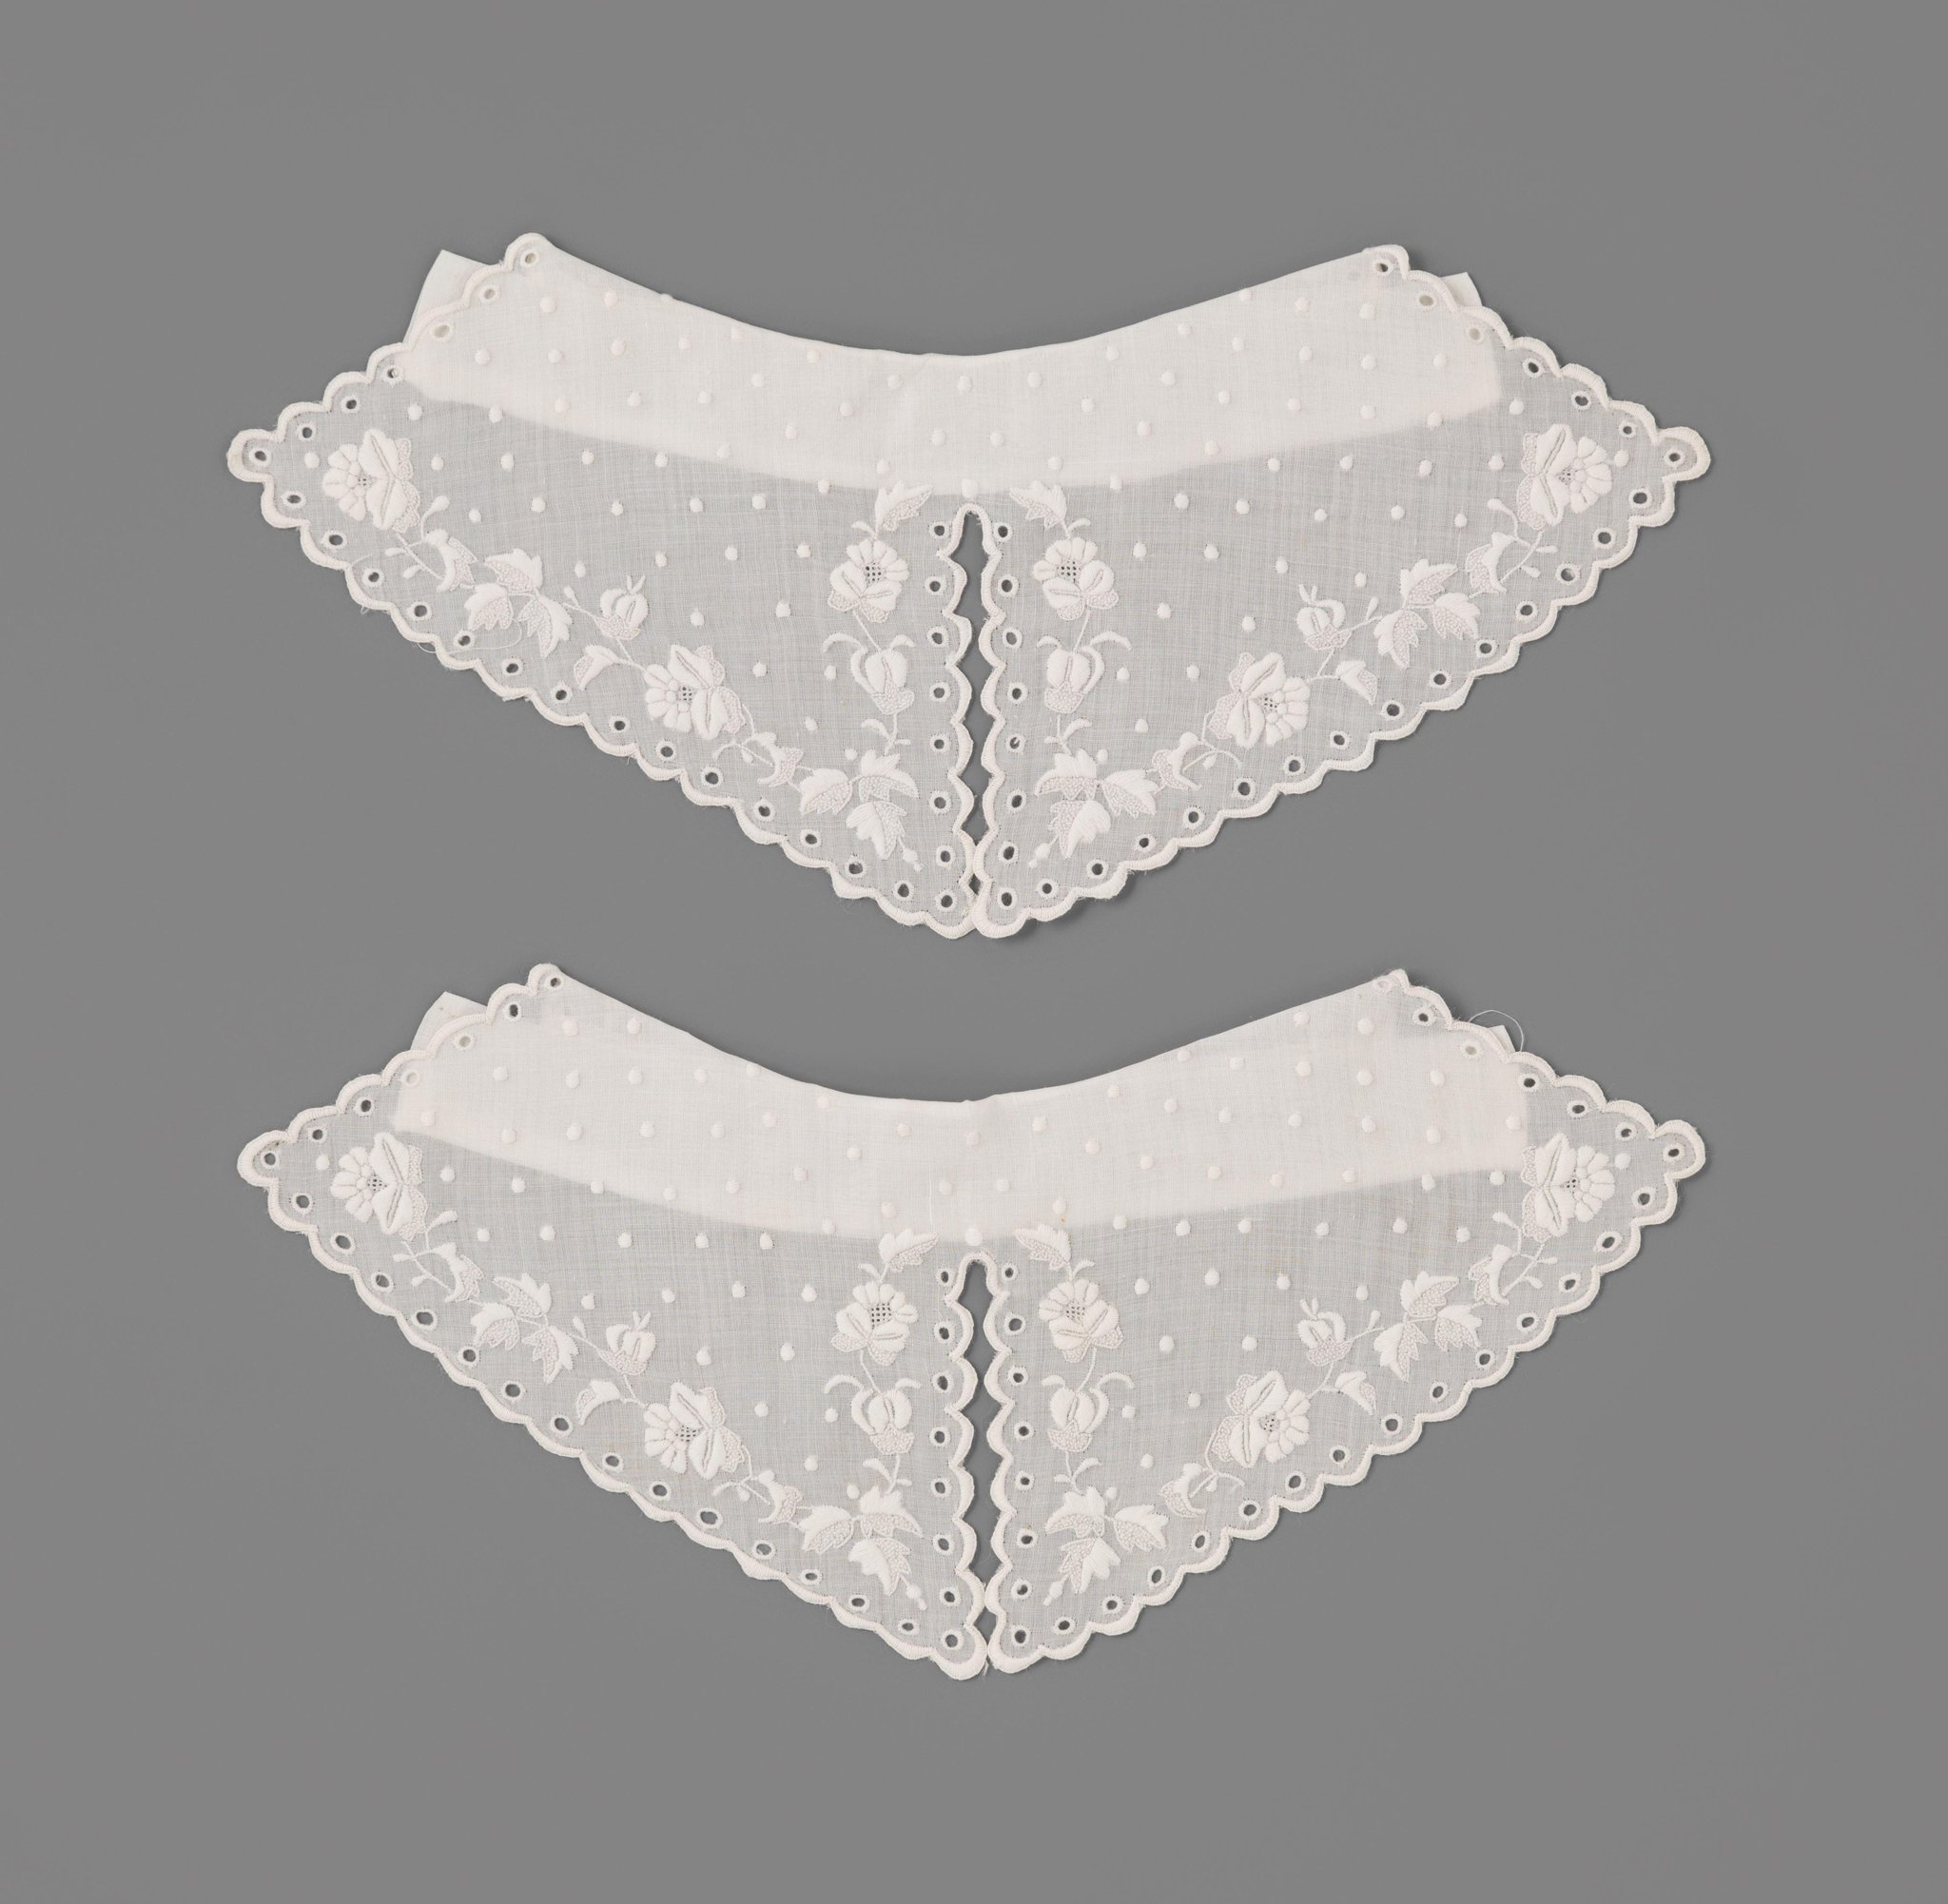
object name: cuff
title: Pand van een kraag of een manchet van batist, dat is versierd met witwerk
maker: Anonymous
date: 1860-1880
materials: textile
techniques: embroidery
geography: switzerland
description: Kraagje uit twee panden, of twee manchetten (à double usage), van batist met plumét-borduursel van palmetbloempjes, knopjes en wingerdblaadjes. Victoriaans. Model: Twee gelijke, in het midden gespleten, platte driehoeken, met afgeknotte punten. Rondom fijn geschulpt. Breed, dubbel stoffen boordje. Patroon: Vlakke schulpjes. Langs het split en de buitenkant staat, symmetrisch een golvende tak, waaraan driemaal de palmetbloem, die deels vol wit geborduurd en deels opengewerkt is, of gestippeld. Op de splithoek staat een groepje van drie wingerdblaadjes, half vol wit, half gestippeld. Op het veld gestrooide moesje. Zwitserland? Toestand: Nieuw.